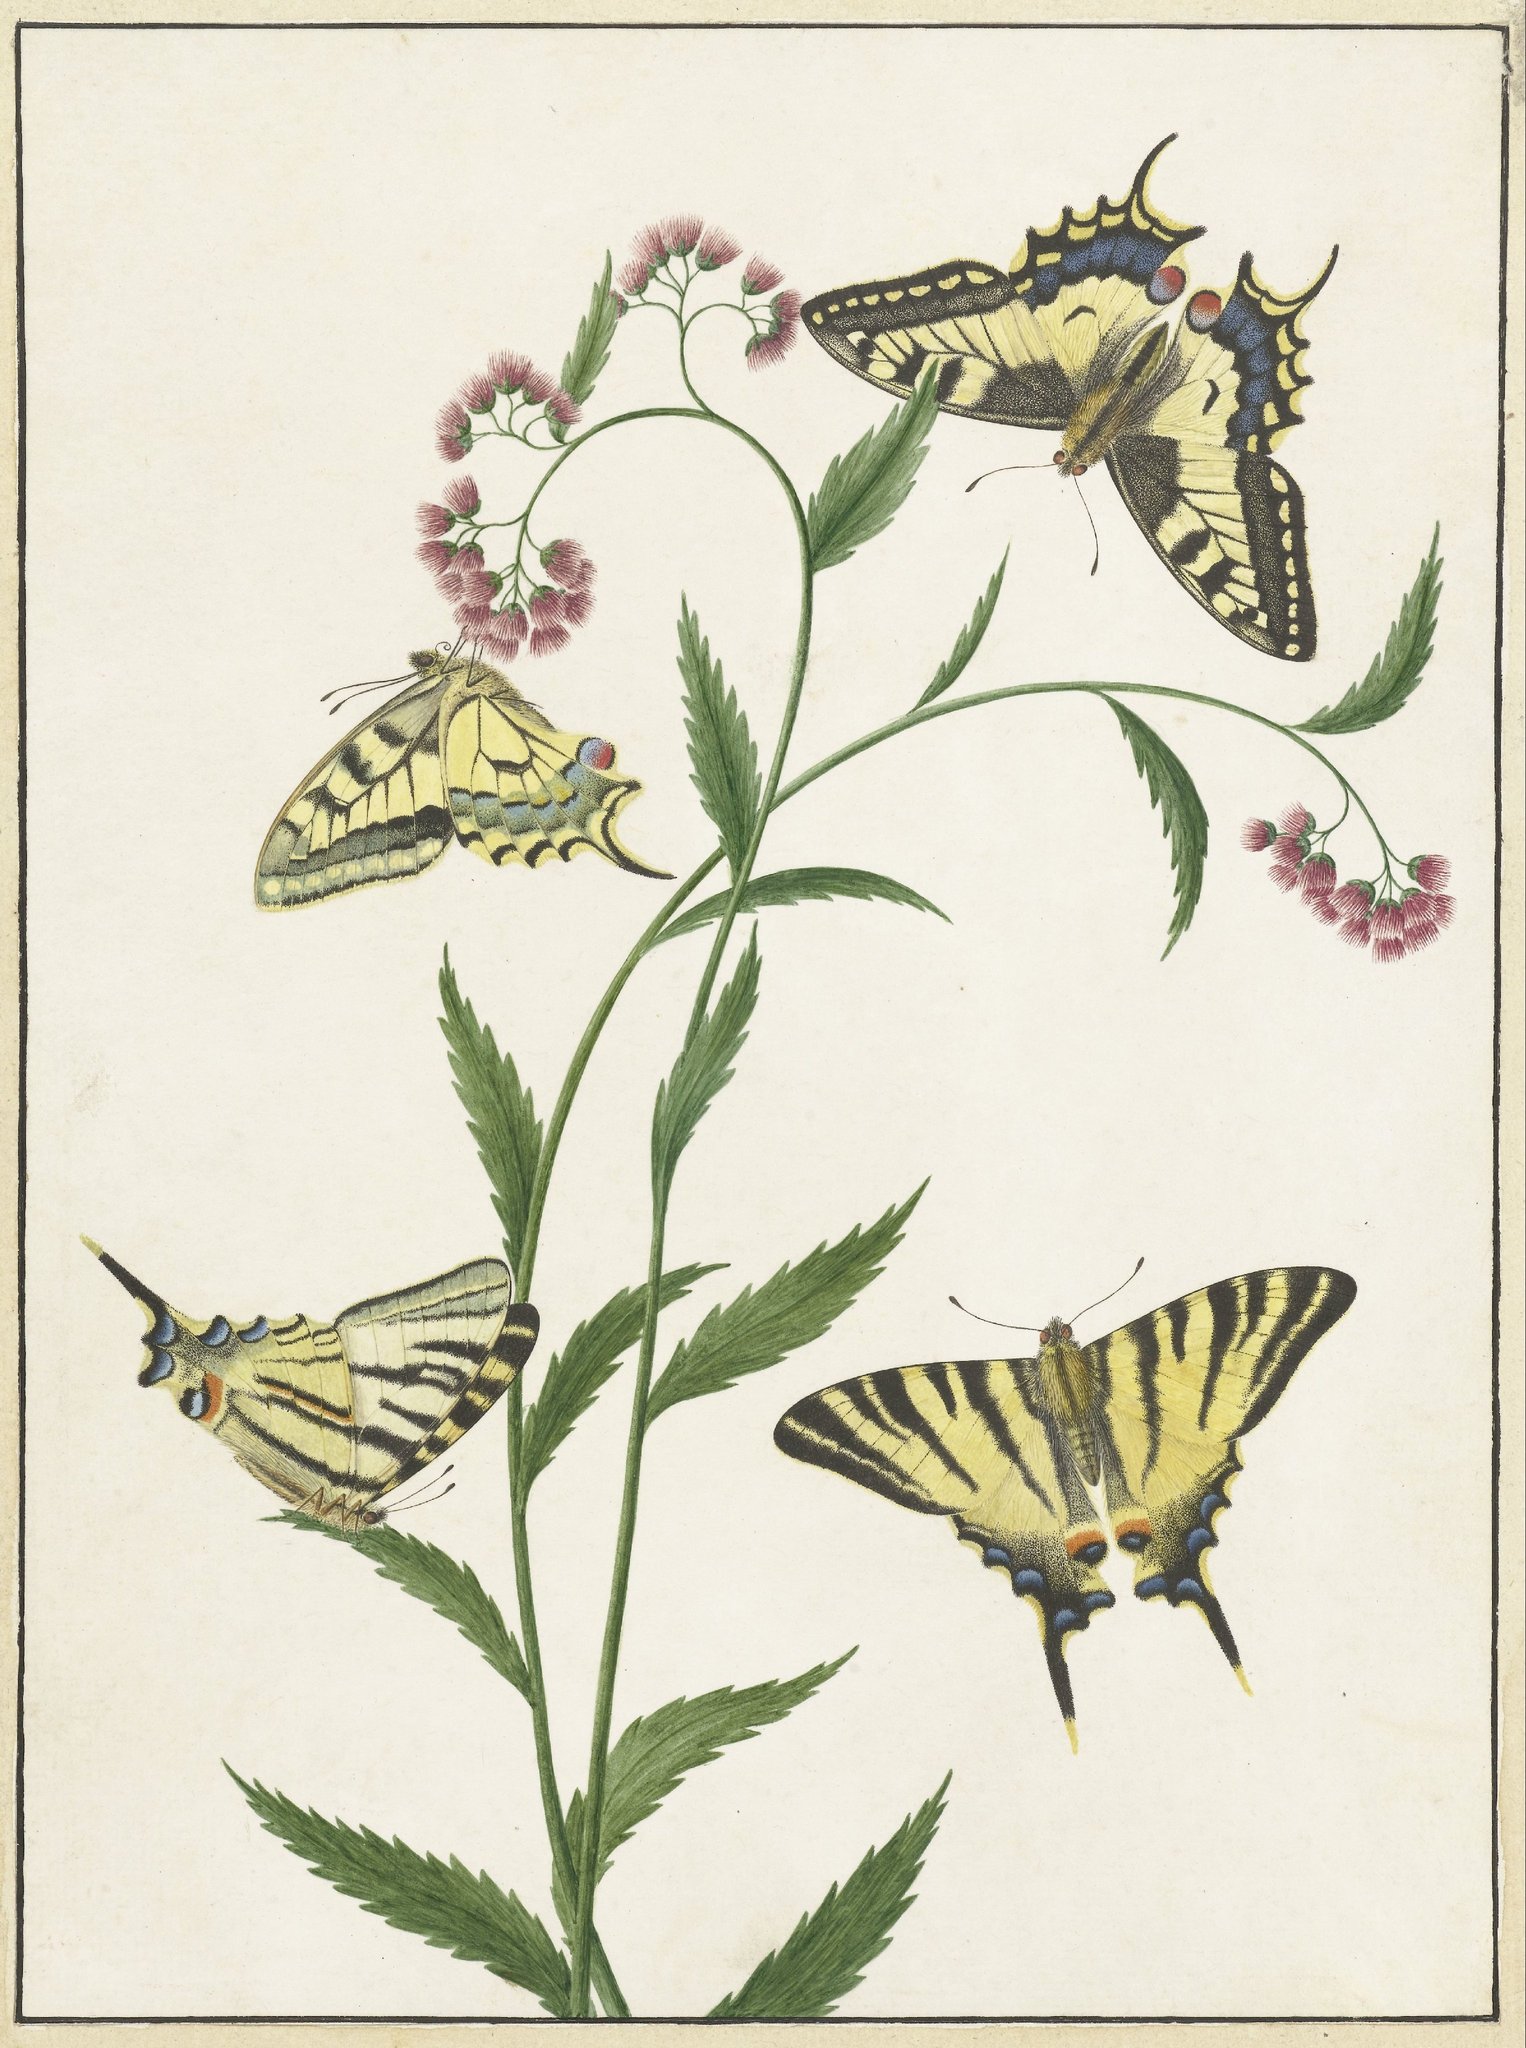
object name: drawing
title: Four Butterflies on Flowers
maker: paulus knogh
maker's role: draughtsman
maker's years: 1737-1802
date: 1747-1802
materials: paint, ink, paper, watercolor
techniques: brush, pen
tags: insects: butterfly